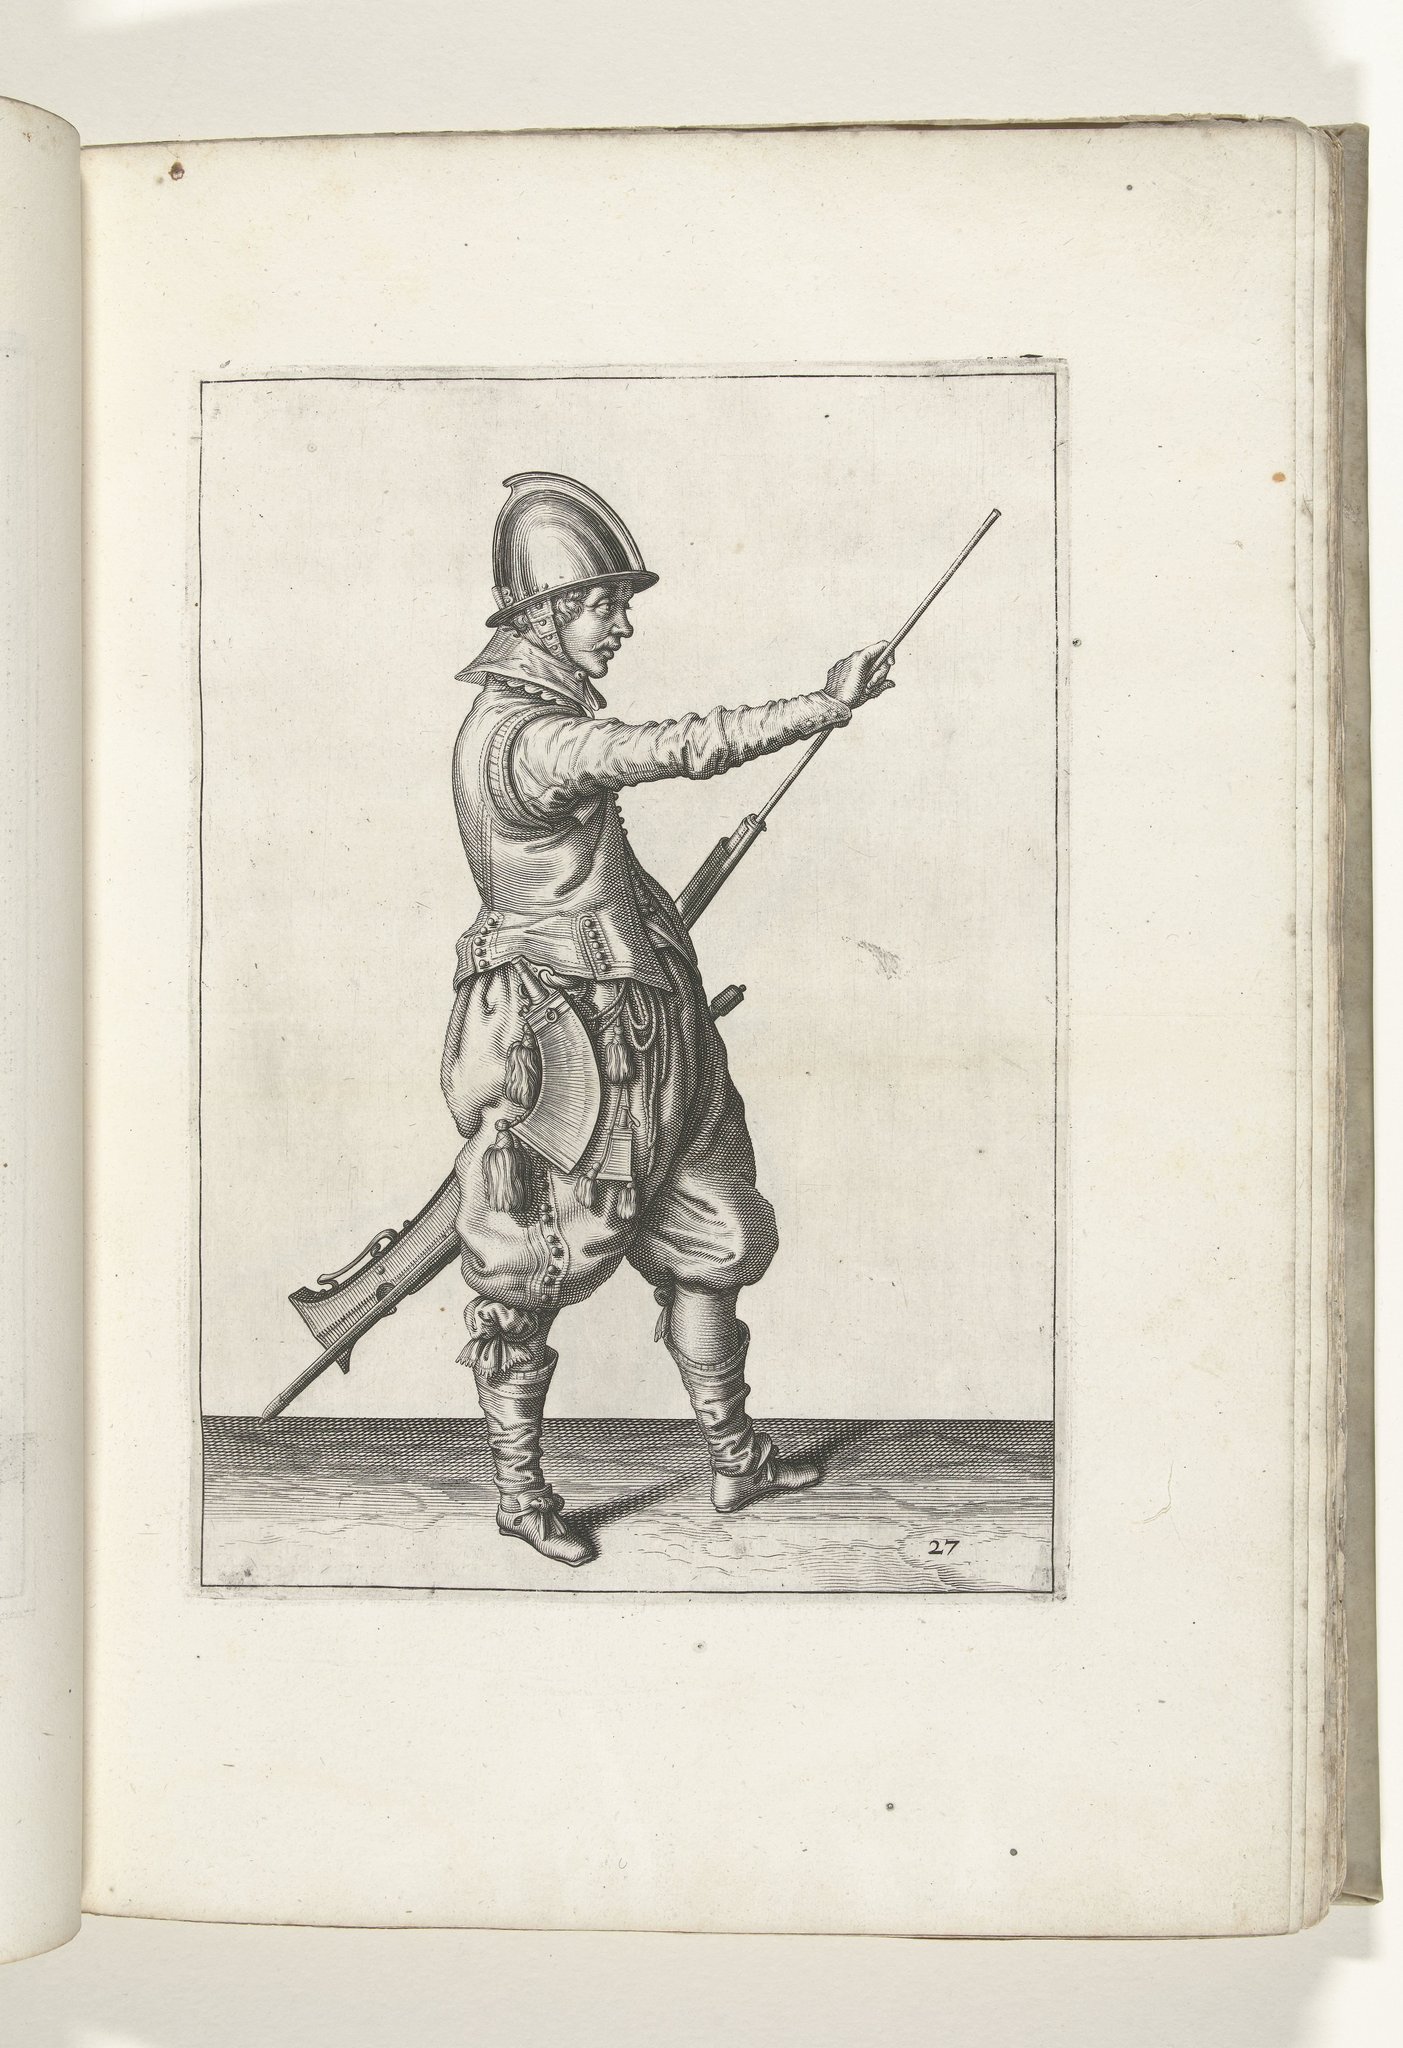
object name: print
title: Soldaat die zijn laadstok uit de loop van zijn roer trekt (nr. 27), ca. 1600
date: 1597-1607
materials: paper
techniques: engraving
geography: northern netherlands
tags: the hague, maurice (prince of orange), handling of weapons ~ military training, weapons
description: Een soldaat, ten voeten uit, naar rechts, die met zijn linkerhand bij zijn linkerdijbeen een roer (een bepaald type vuurwapen) vasthoudt en met zijn rechterhand zijn laadstok uit de loop trekt (nr. 27), ca. 1600. Plaat 27 in de instructies voor het hanteren van de roer: Corte onderwysinghe op de figuerliicke afbeeldinghe, belanghende t'rechte ghebruyck des Roers. Onderdeel van de illustraties in: J. de Gheyn, Wapenhandelinghe van Roers Musquetten ende spiessen, 's-Gravenhage, 1607. Krijgswezen rond 1600.